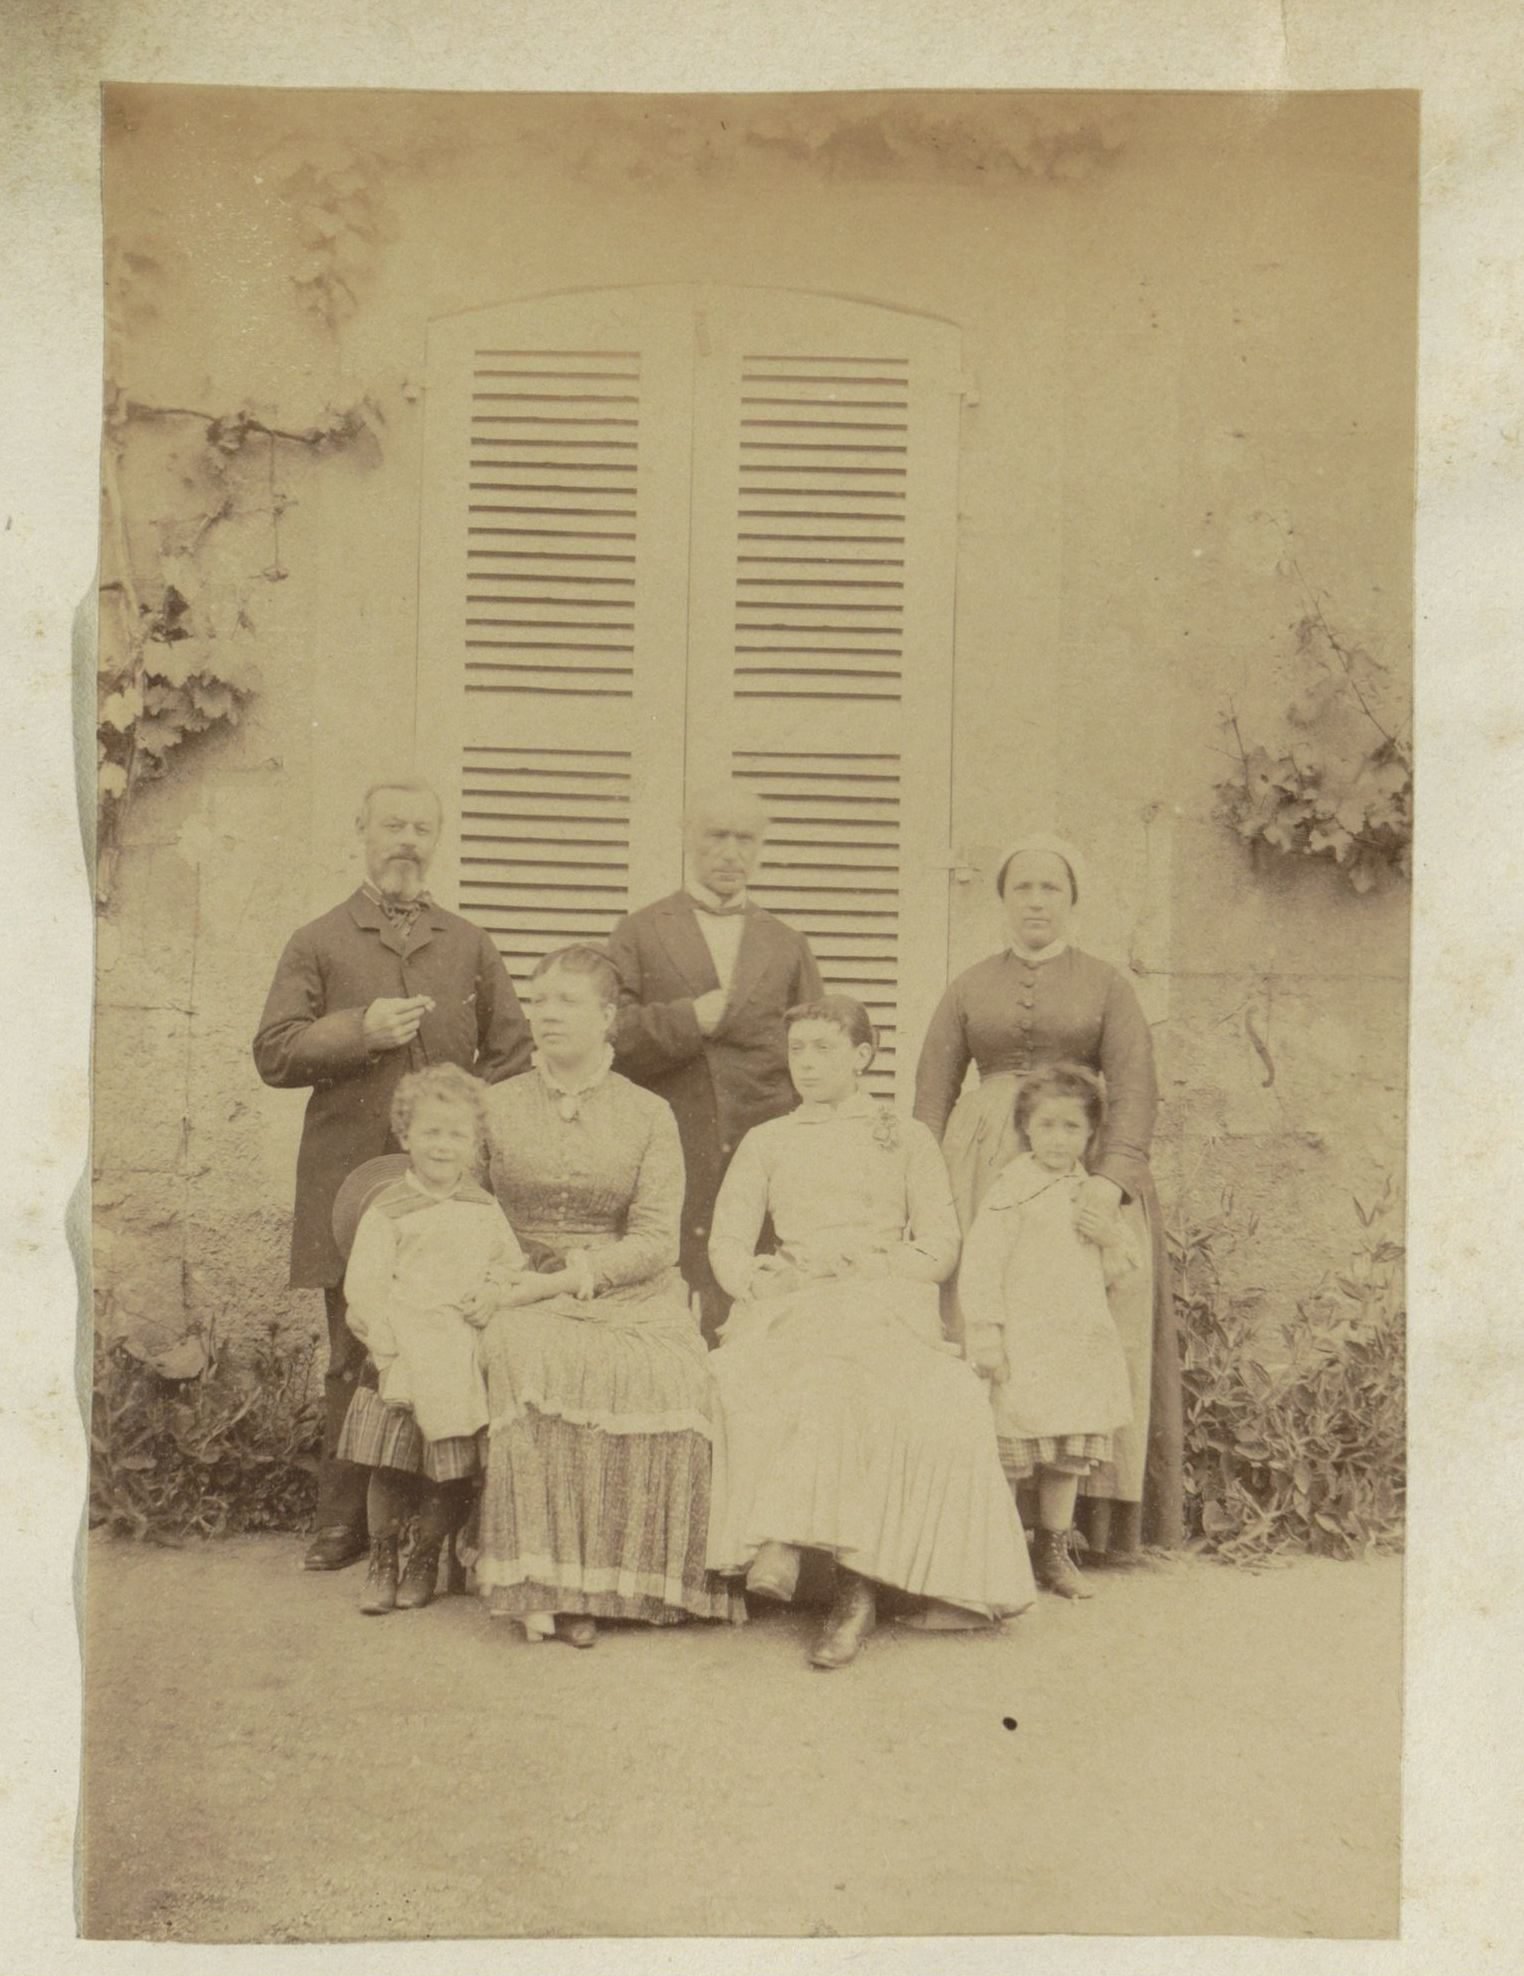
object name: photograph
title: Groepsportret van twee mannen, drie vrouwen en twee kinderen staand voor een huis in Frankrijk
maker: Anonymous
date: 1805-1883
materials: photographic support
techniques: albumen print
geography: france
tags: family group, especially parents with their child(ren)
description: Onderdeel van Album van een Franse amateurfotograaf met opnames van familie, militairen, industrie, landschappen en bezienswaardigheden in Frankrijk.